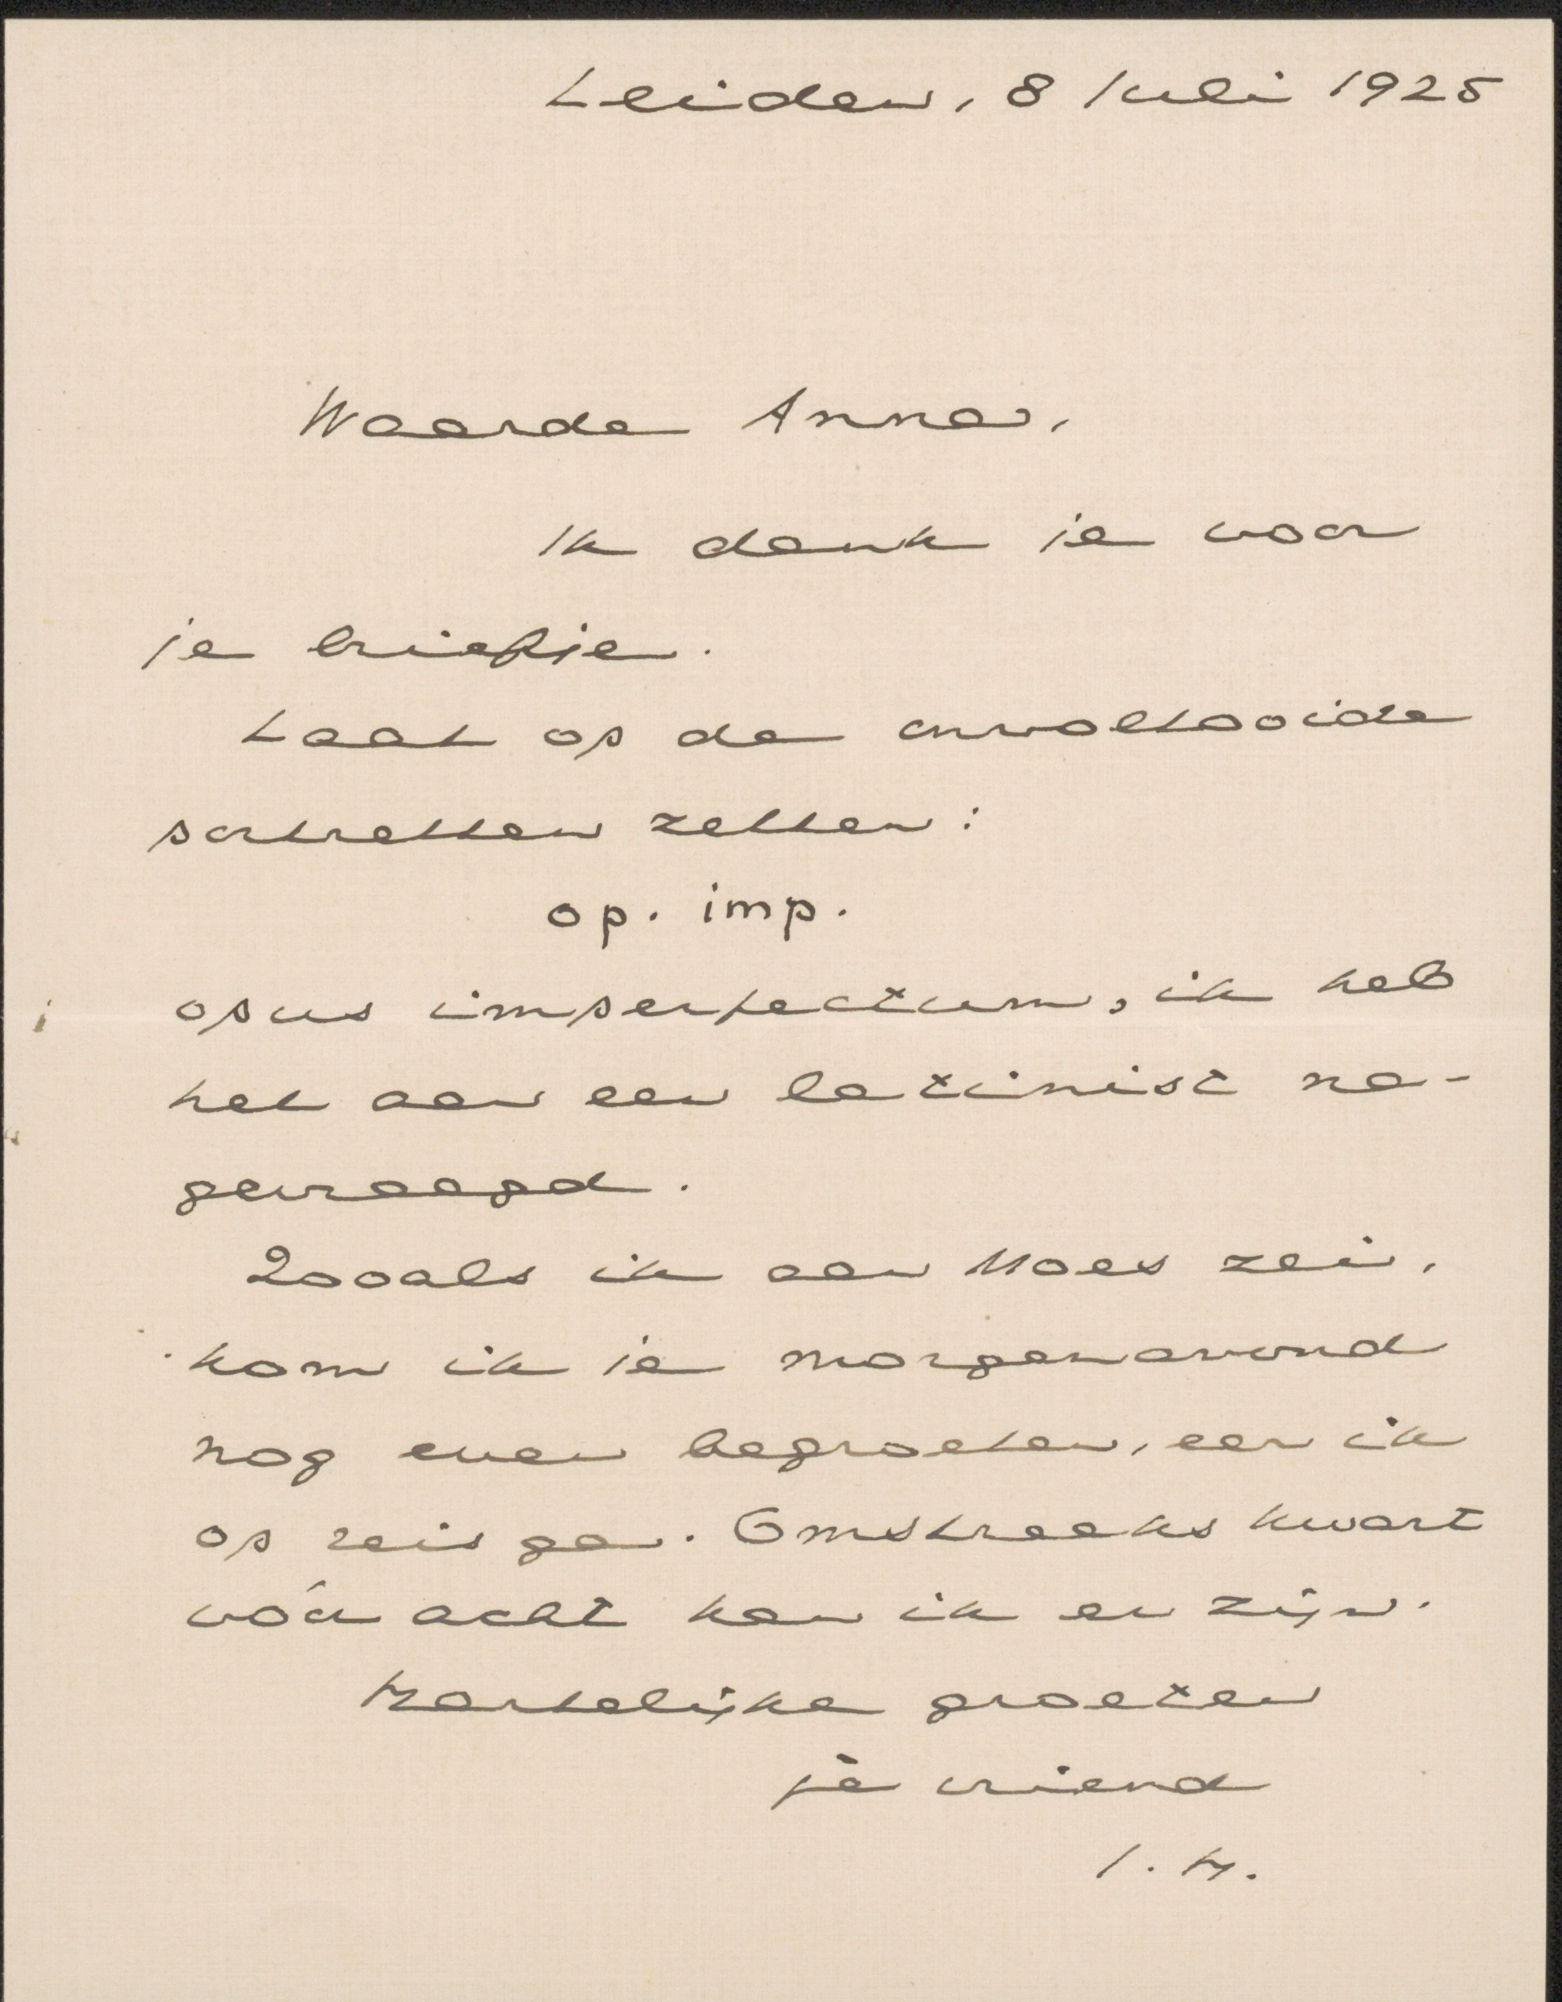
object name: letter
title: Brief aan Anna Dorothea Dirks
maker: johan huizinga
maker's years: 1872-1945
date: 1925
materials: ink, paper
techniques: pen, writing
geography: leiden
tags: dordrecht, amsterdam, painter, draughtsman, designer, jan veth, artist, anna dorothea dirks, engineer, historical persons (portraits and scenes from the life)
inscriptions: collector's mark: ‘RPK’